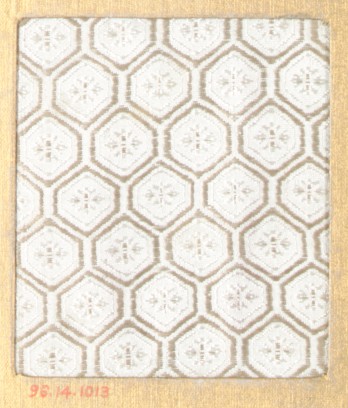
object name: piece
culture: japanese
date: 1701-1900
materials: silk